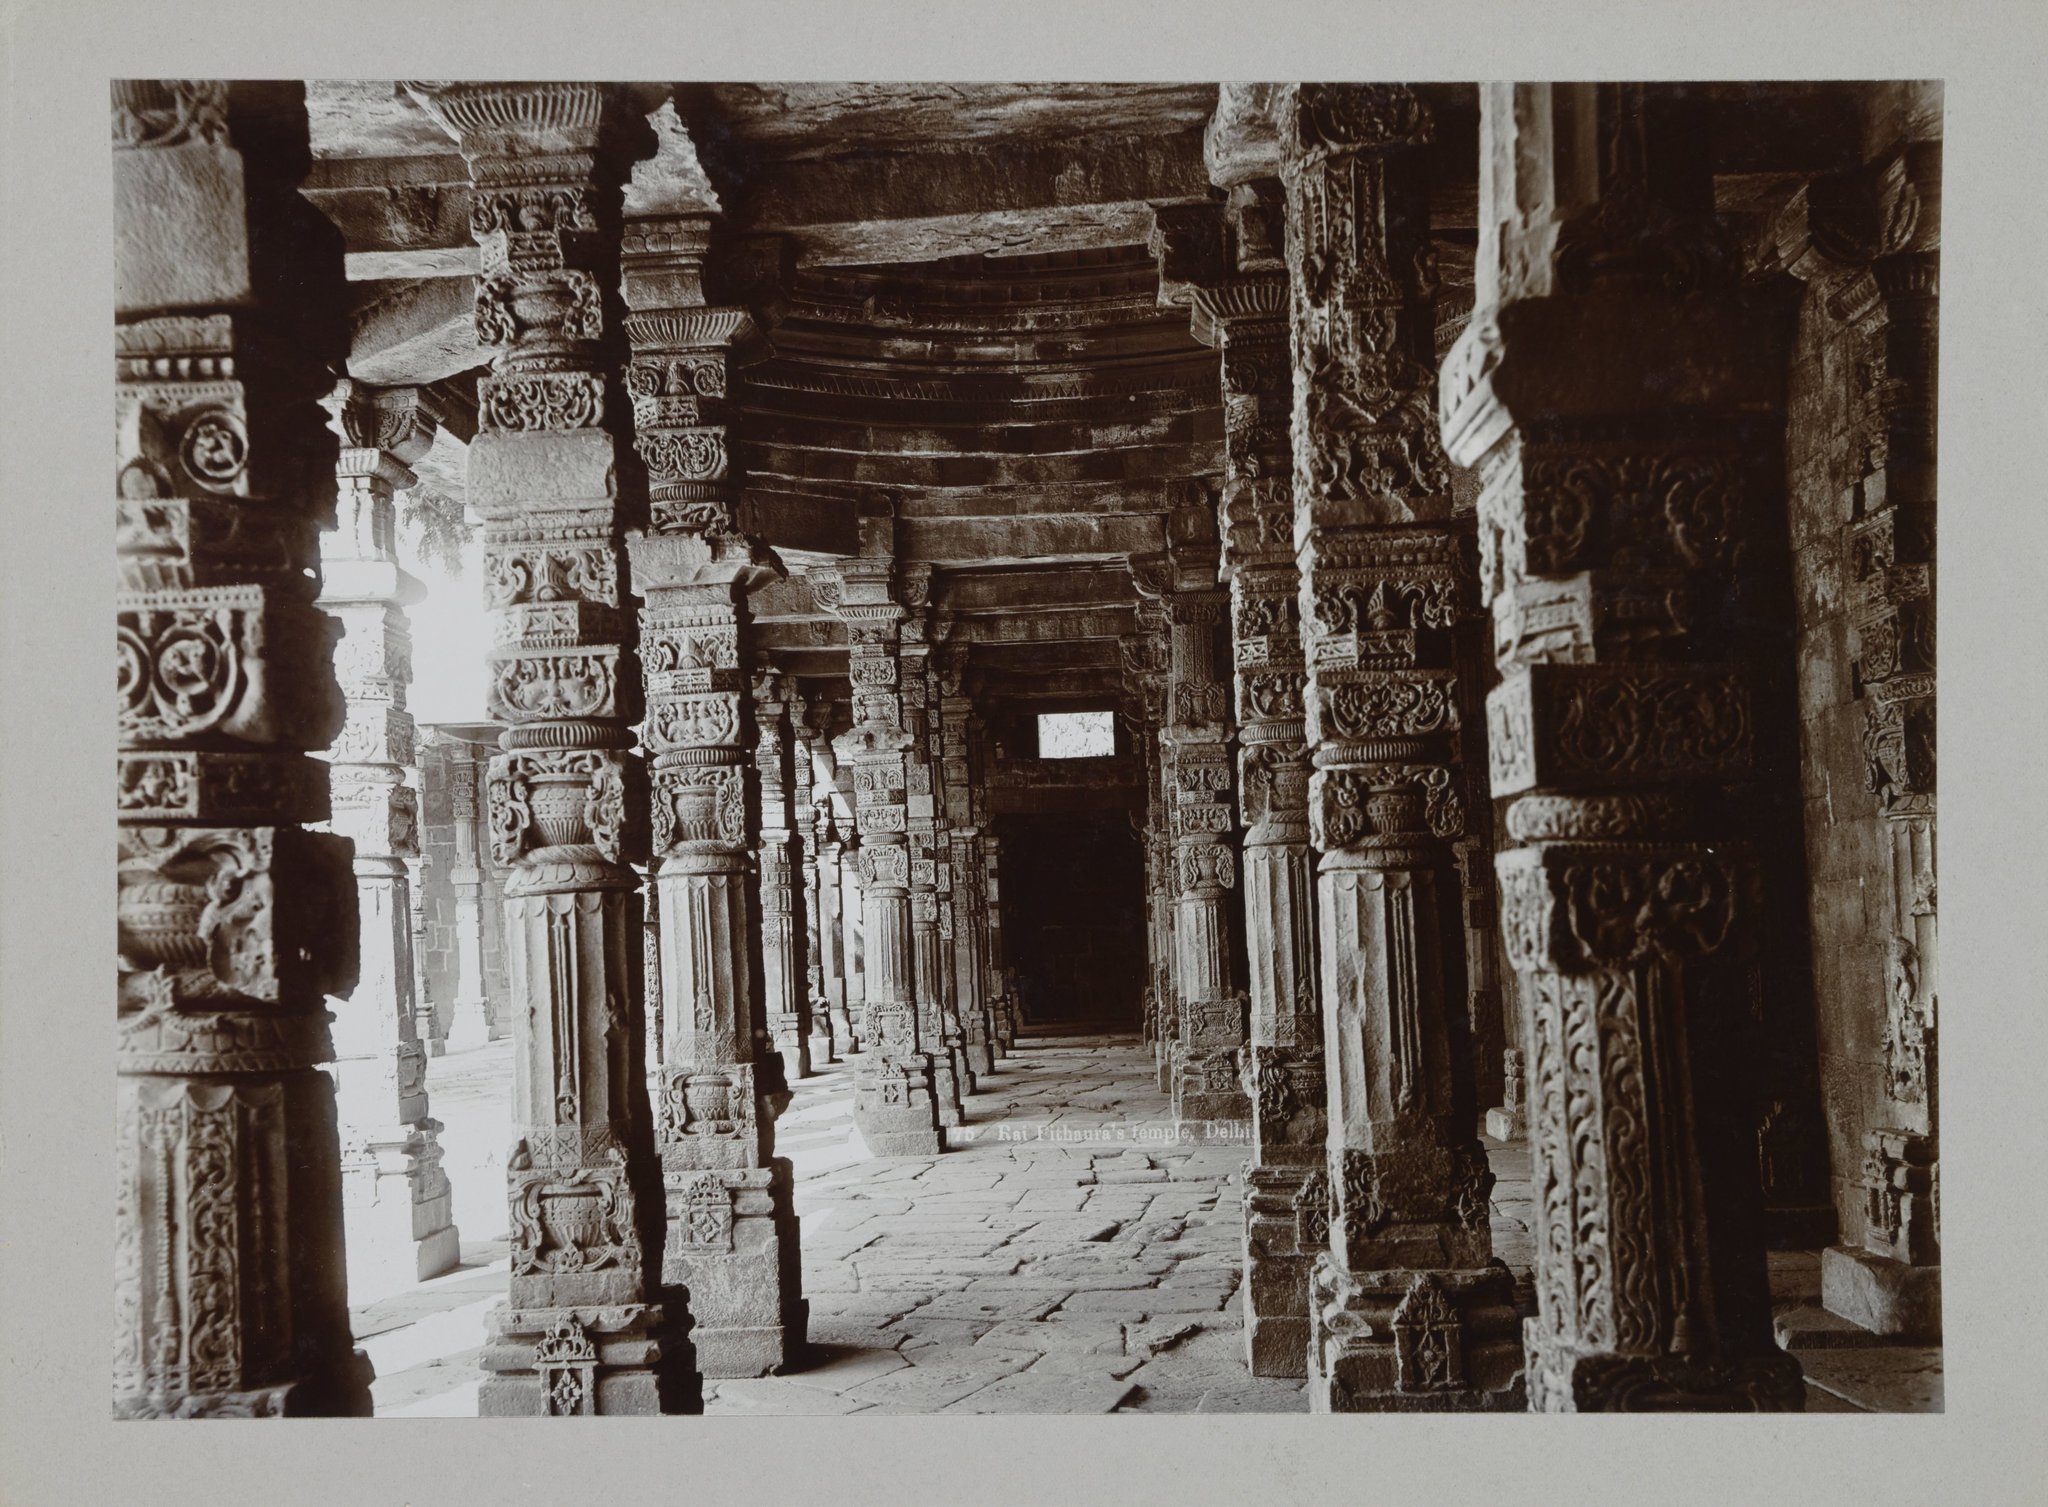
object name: photograph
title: Rai Pithora fort in the Qutb complex, Delhi, India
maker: Anonymous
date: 1895-1915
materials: cardboard, paper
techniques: gelatin silver print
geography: delhi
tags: delhi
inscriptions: inscription: ‘75 Rai Pithaura's temple, Delhi.’, annotation: ‘43. Rai Tithauca tempel b/d Kutab Minar.’